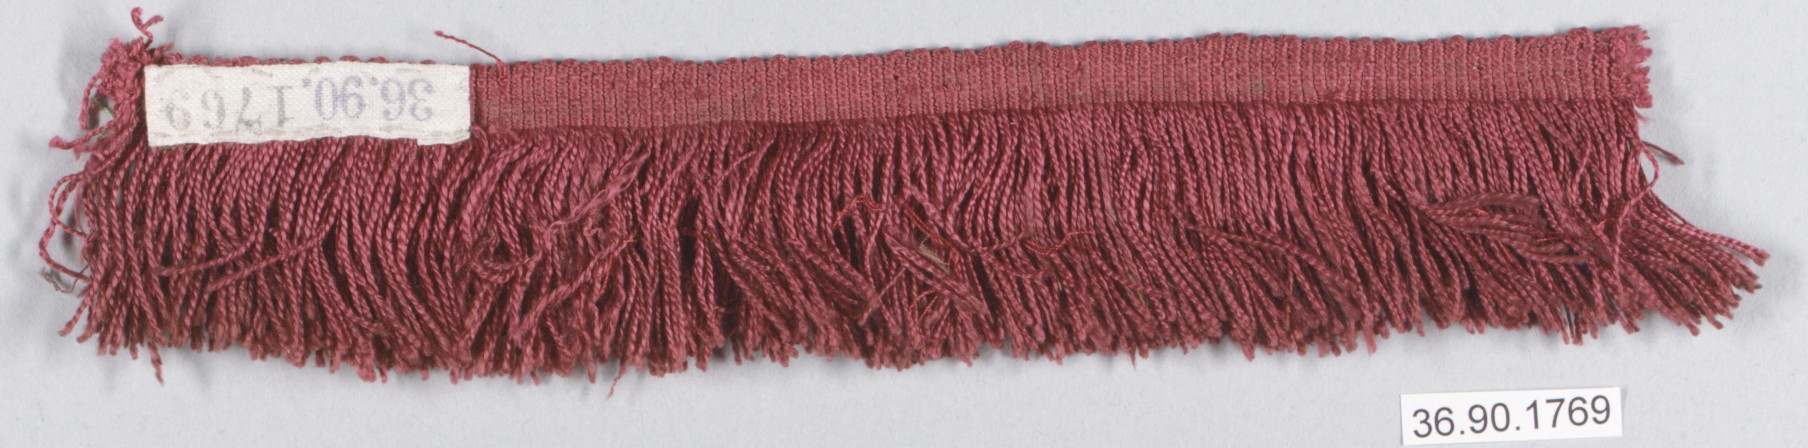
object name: fringe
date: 1867-1900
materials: silk